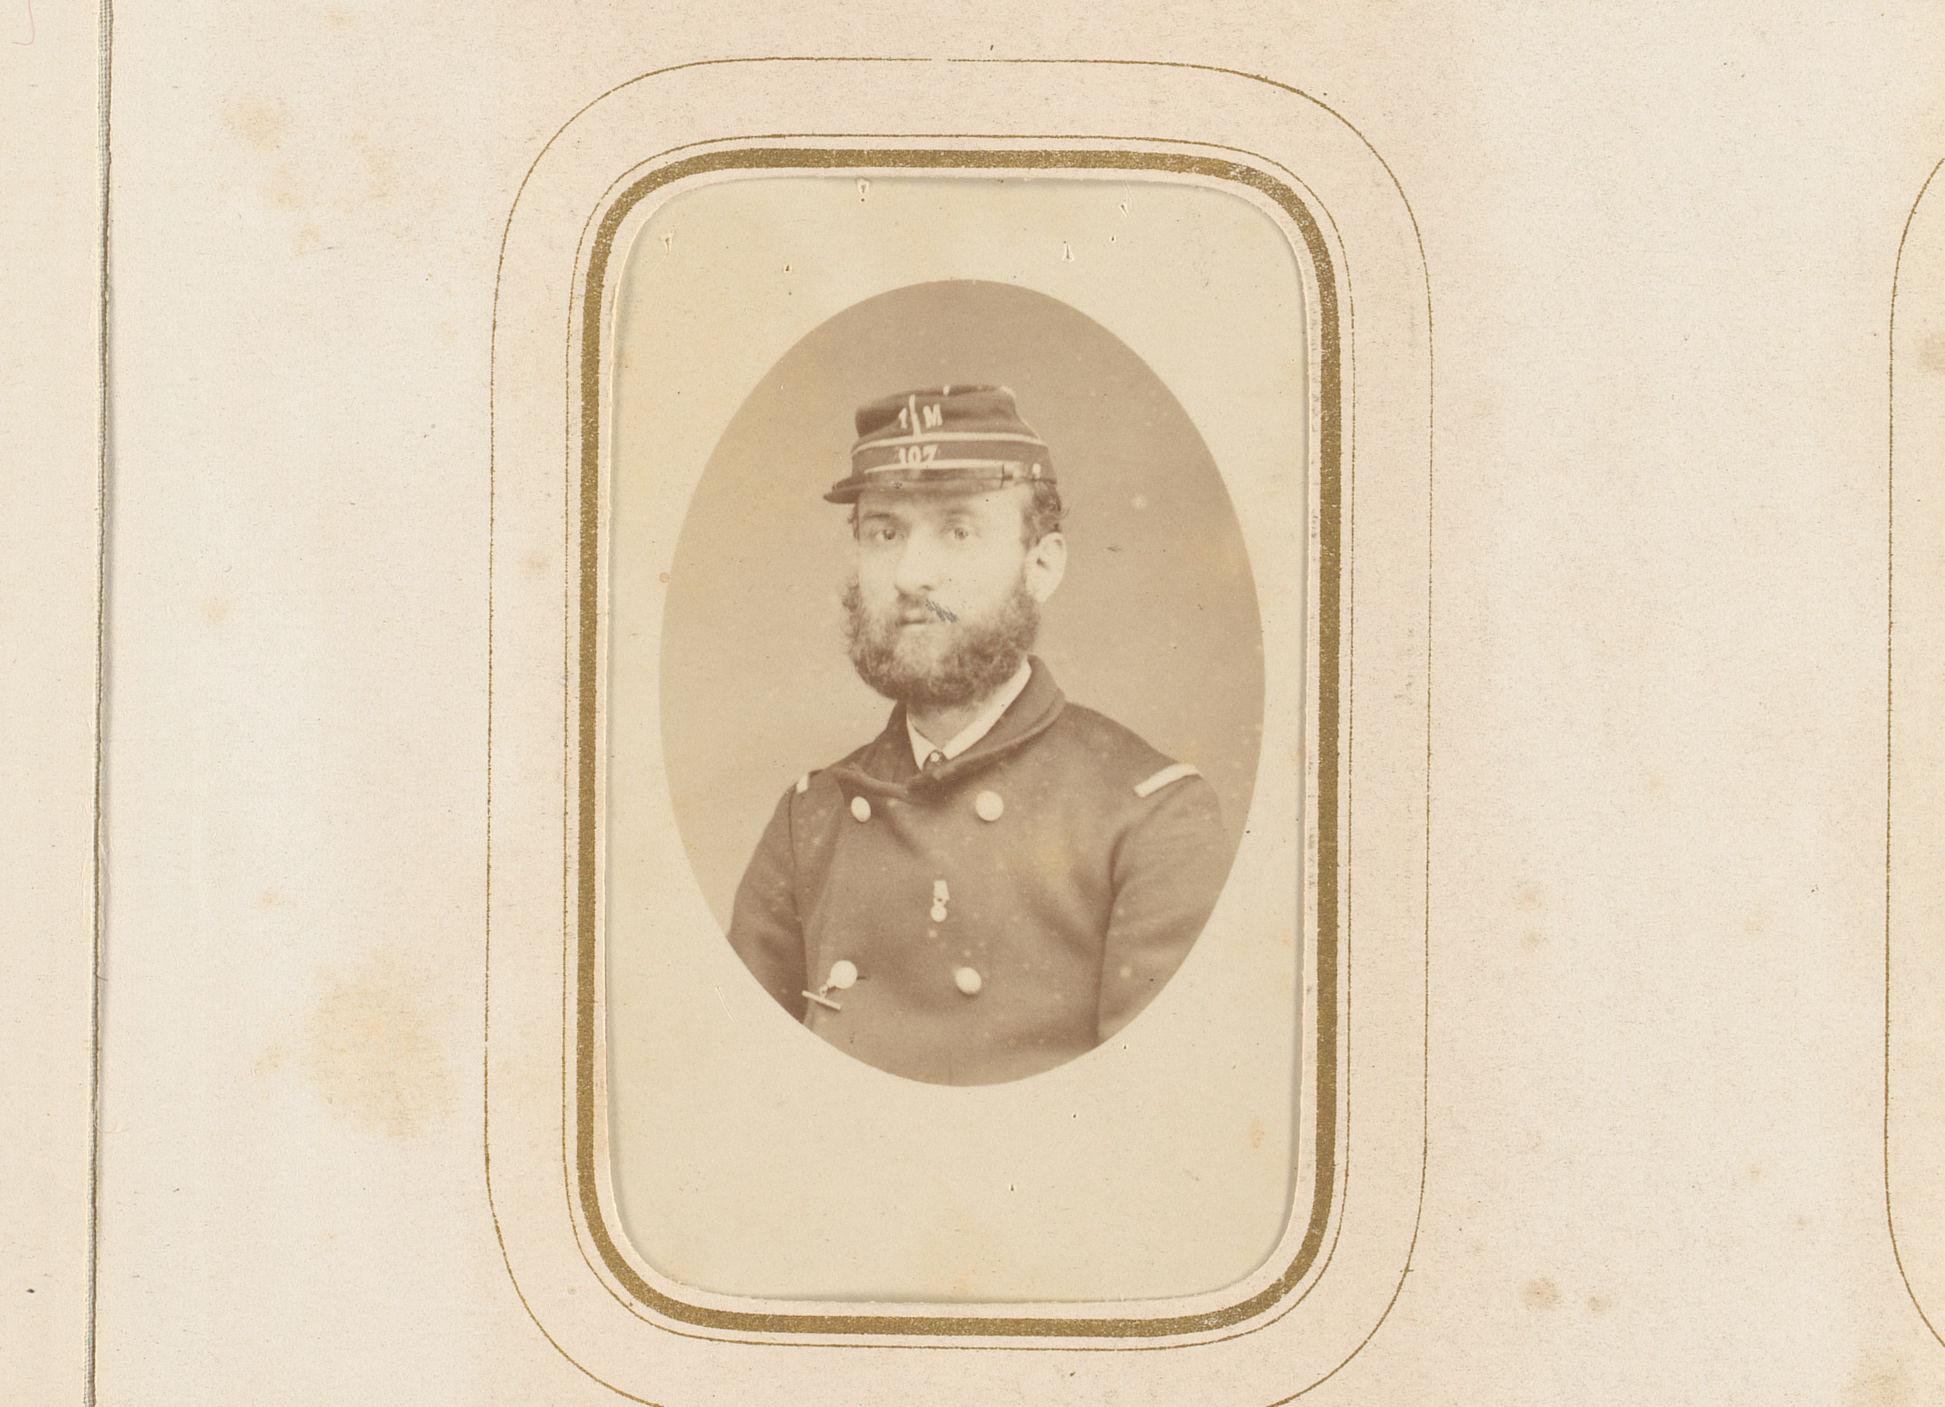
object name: photograph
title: Portret van een man met baard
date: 1860-1890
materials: cardboard, photographic support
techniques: albumen print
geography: paris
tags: historical persons, beard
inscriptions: inscription: ‘Photographie/ Lavy & Gougenheim/ 18, Bould. St. Martin/ à coté du théâtre/ Paris’